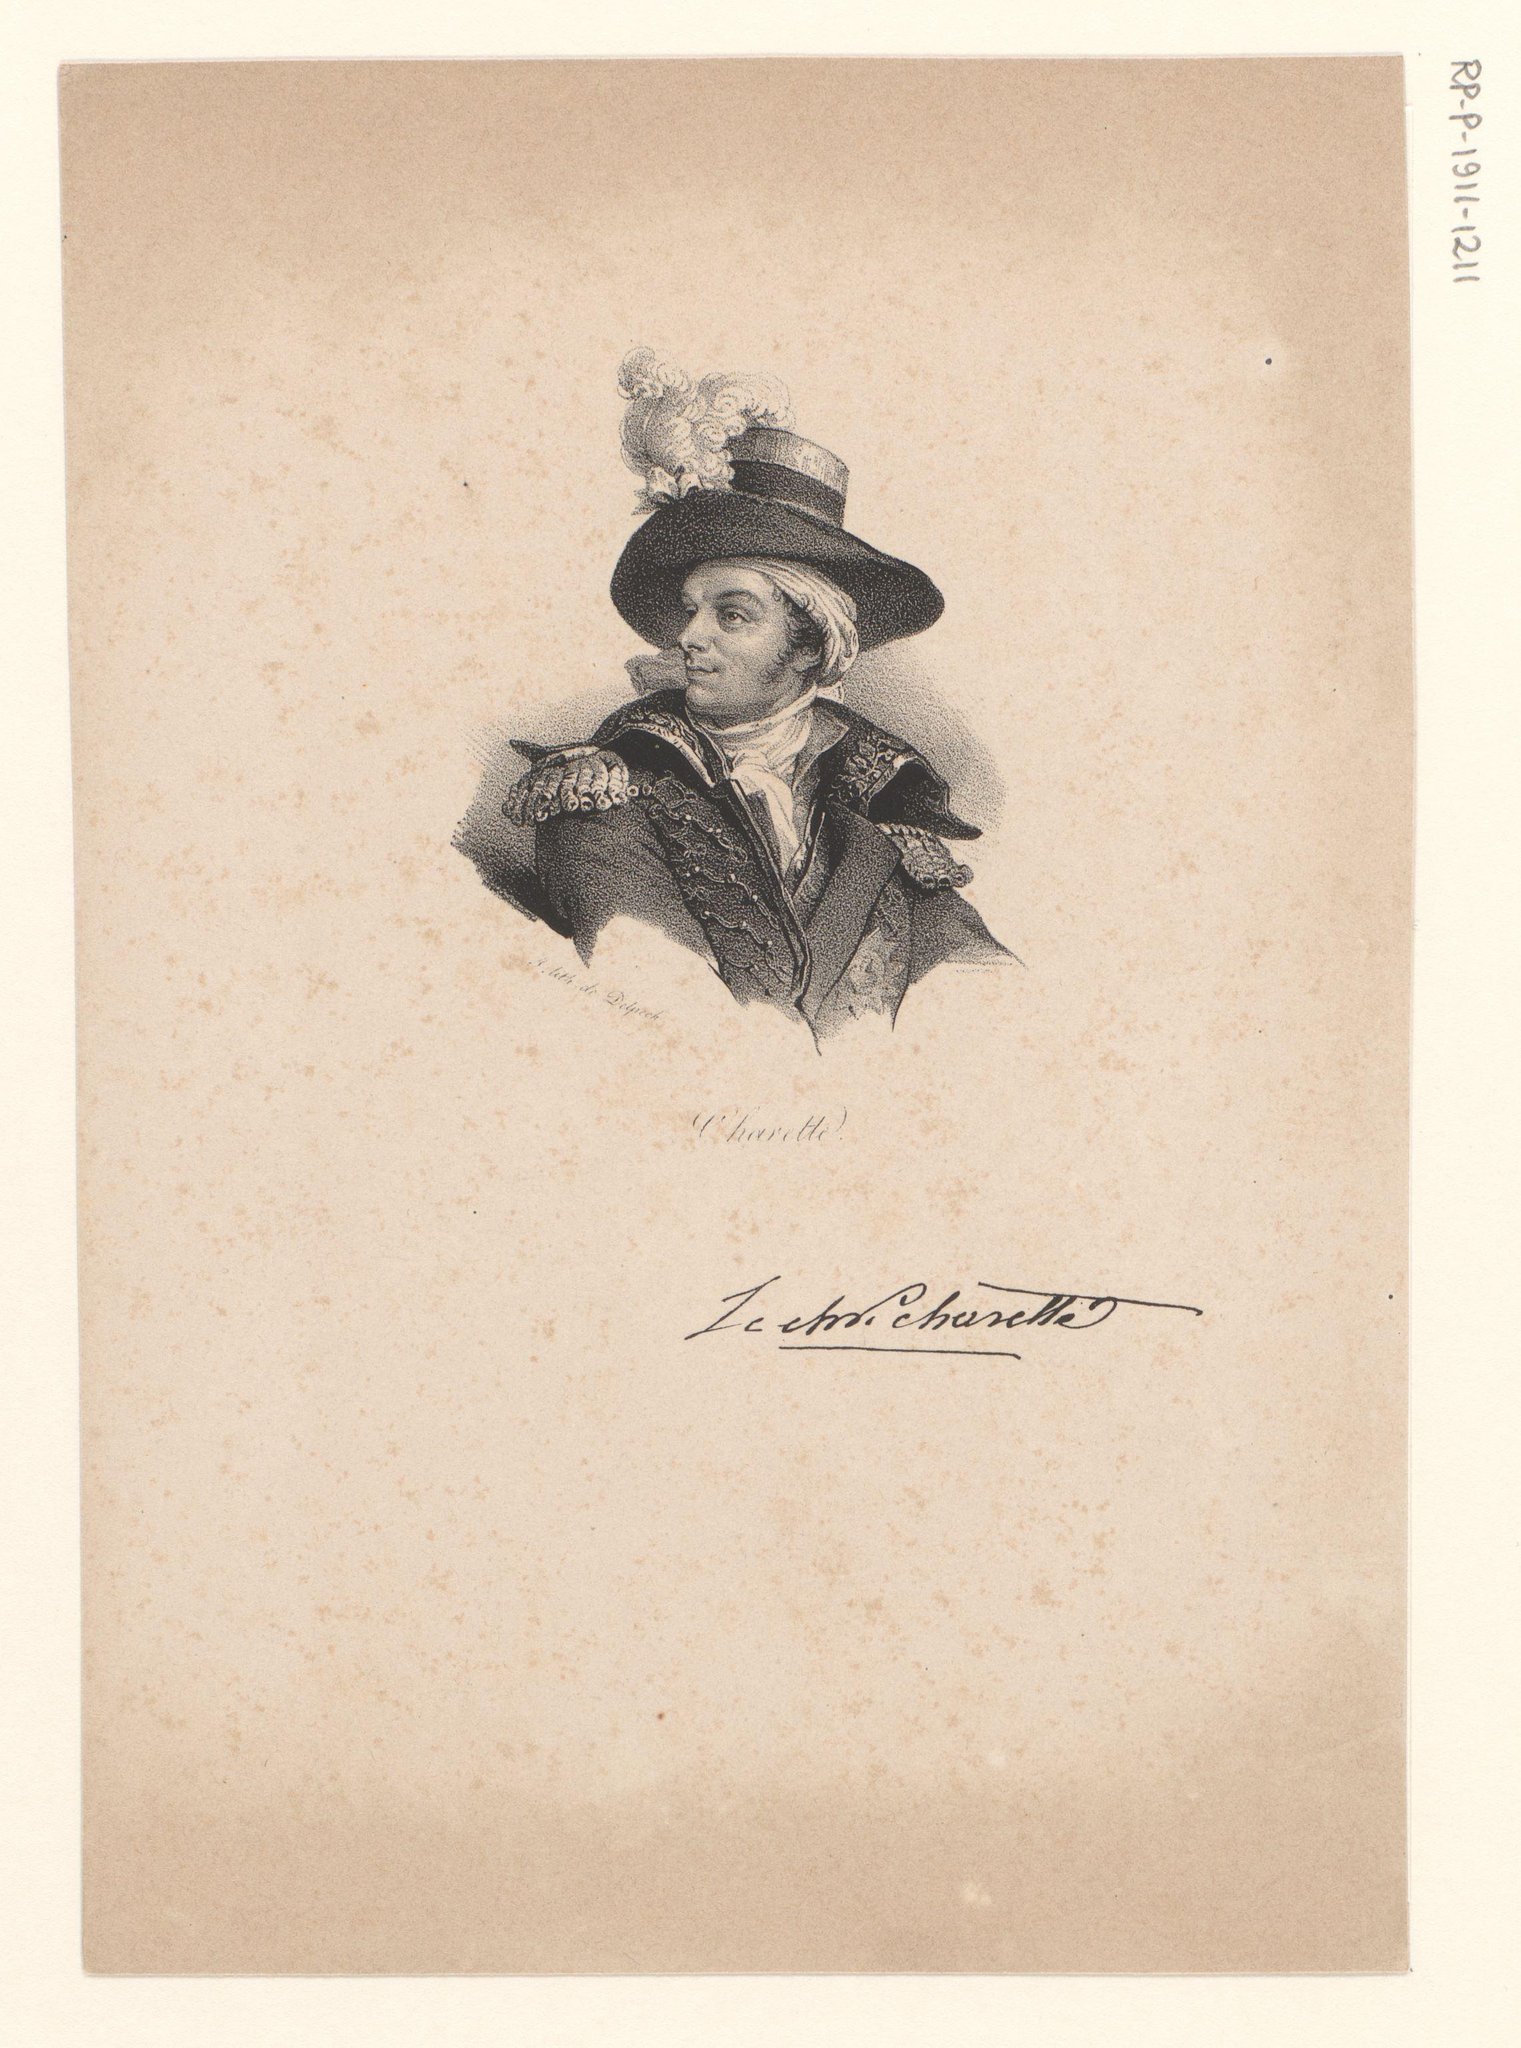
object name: print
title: Charette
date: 1818-1842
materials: paper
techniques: lithograph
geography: paris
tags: historical persons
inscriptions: collector's mark: Lugt 2228a